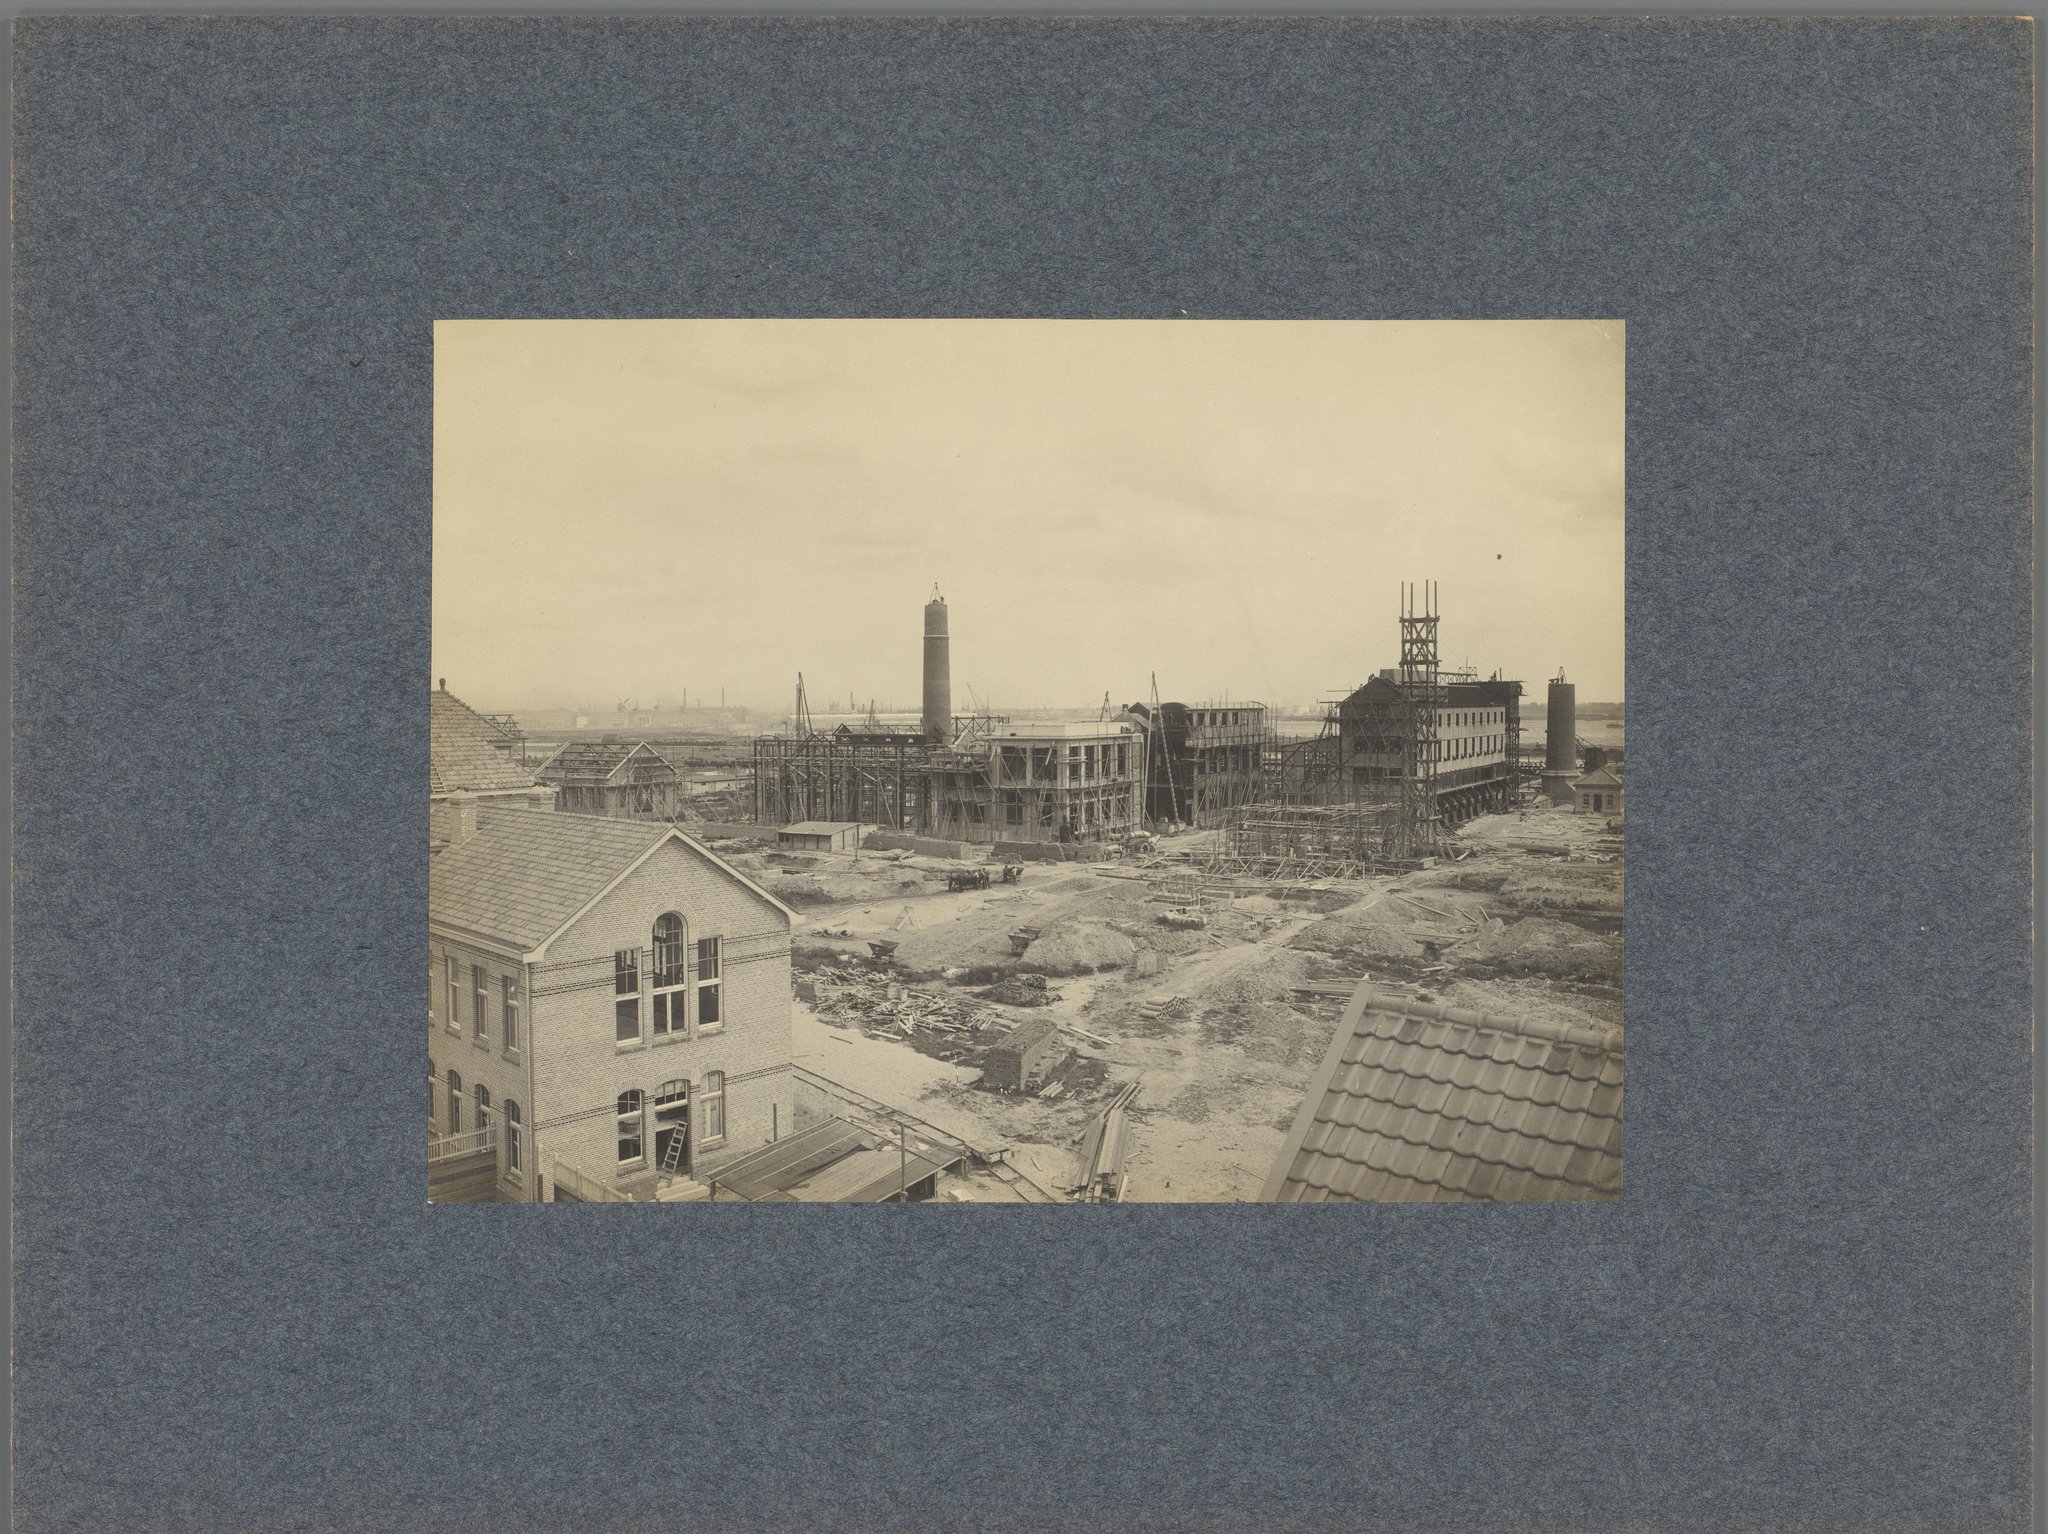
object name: photograph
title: Gezicht op een bouwplaats in de Keilehaven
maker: willem sr. bleuzé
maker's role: fotograaf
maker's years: 1873-1948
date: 1912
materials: paper, cardboard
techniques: gelatin silver print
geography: rotterdam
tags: factory-building, bridge, building-site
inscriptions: inscription: ‘Gezicht/ [...] V/d Keilehaven’, address: ‘W. BLEUZÉ/ ROTTERDAM/ JONKER FRANSSTRAAT 66’